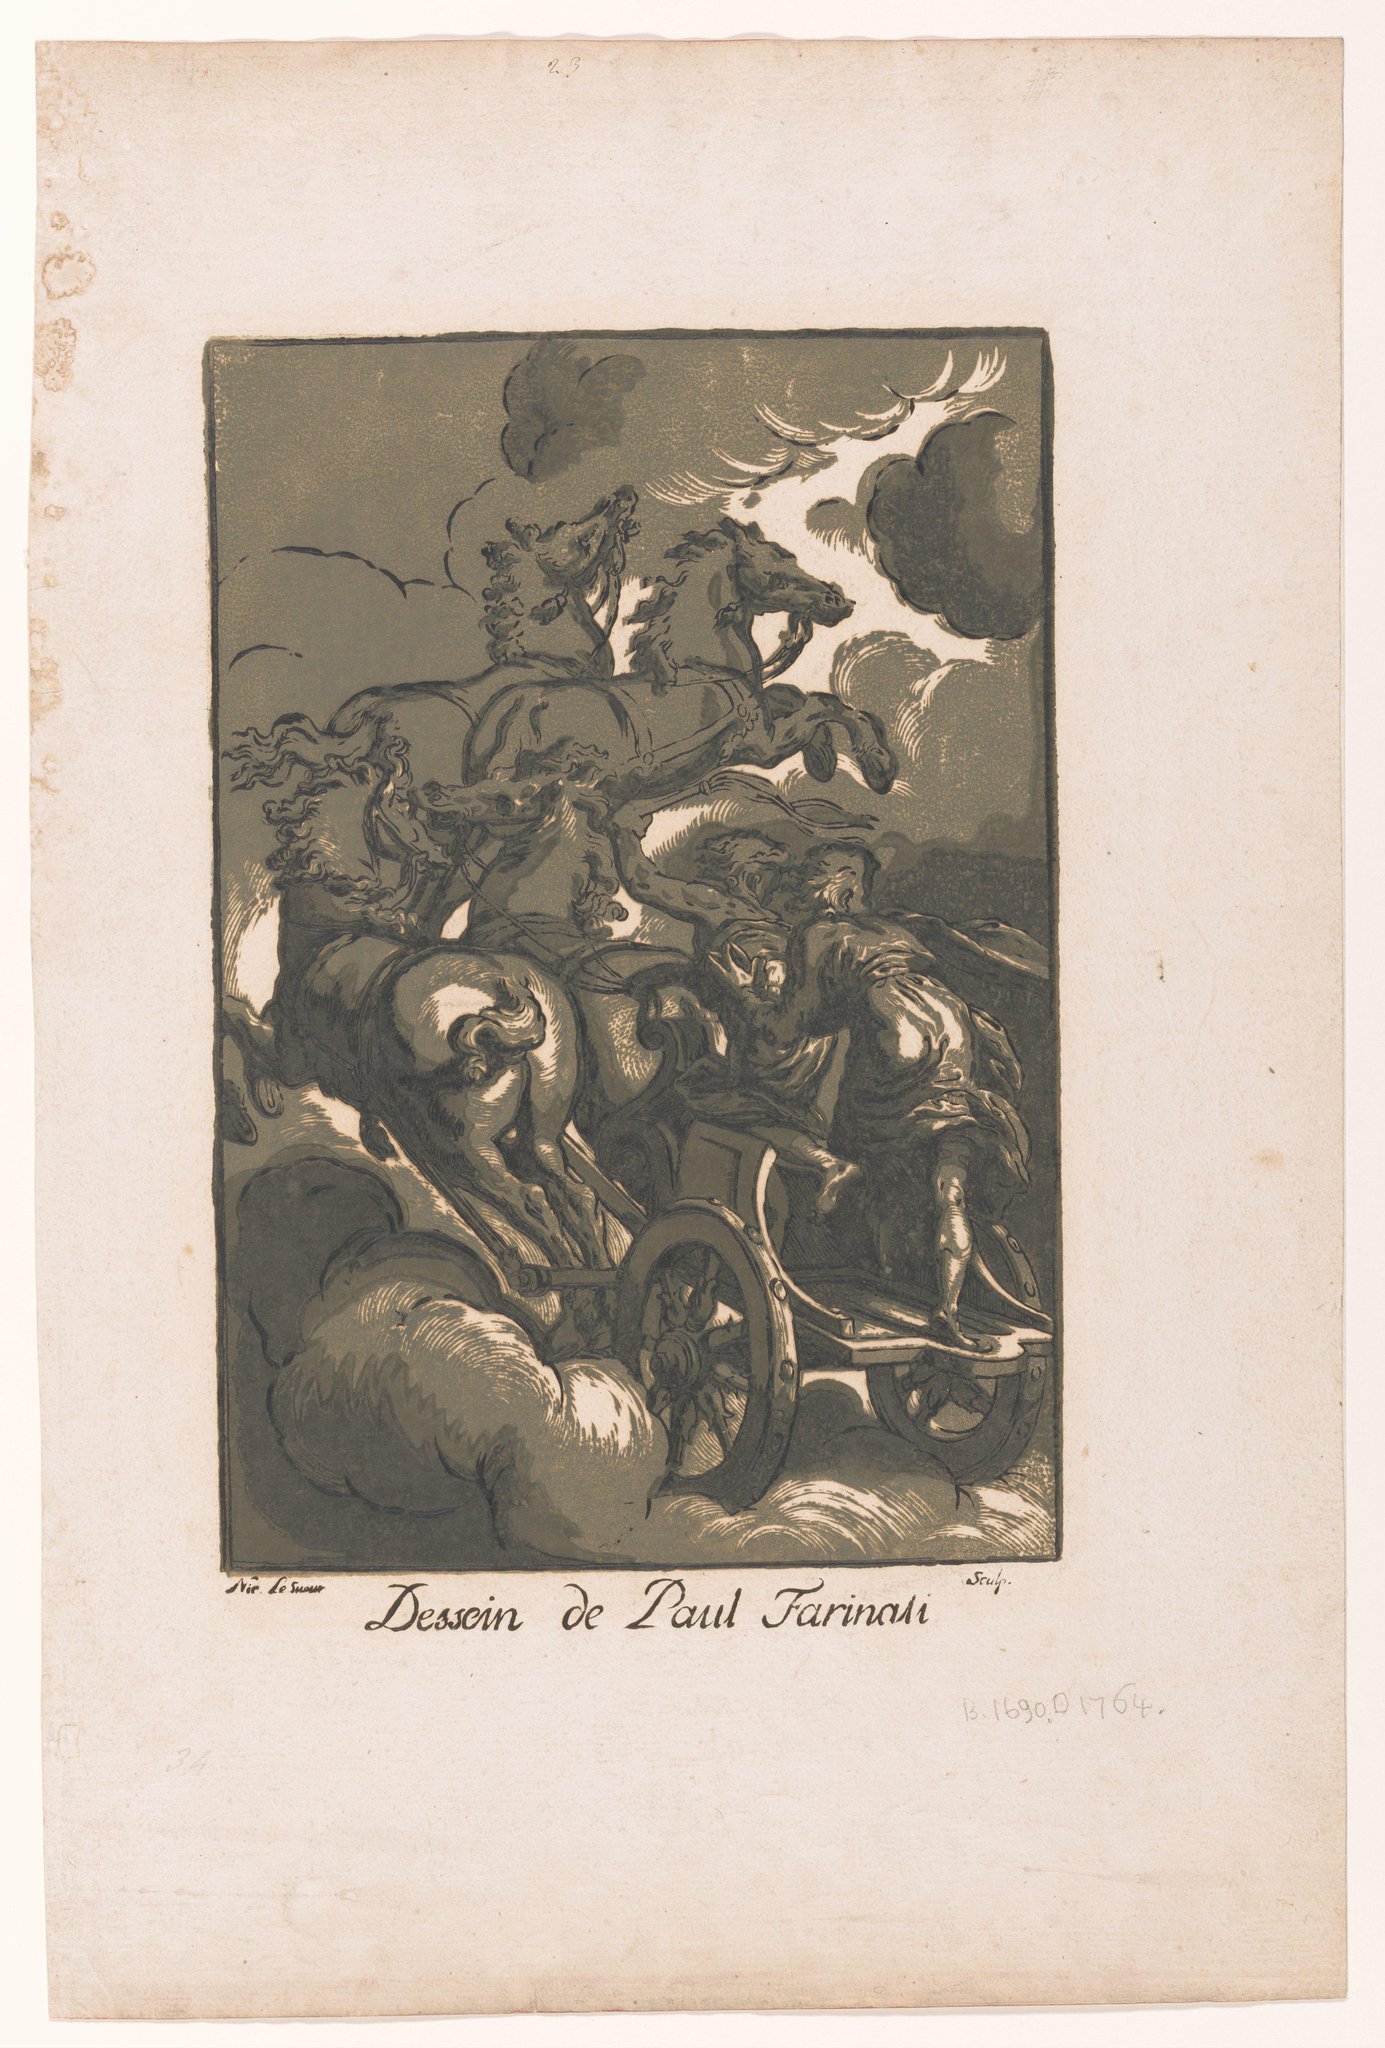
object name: print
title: Recueil d'estampes d'après les plus beaux tableaux et d'après les plus beaux desseins qui sont en France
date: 1729-1740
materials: paper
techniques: woodcut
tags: apollo in the chariot of the sun, drawn by four horses, usually preceded by aurora holding a torch; 'carro del sole' (ripa)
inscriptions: collector's mark: Lugt 2228, collector's mark: Lugt 2760